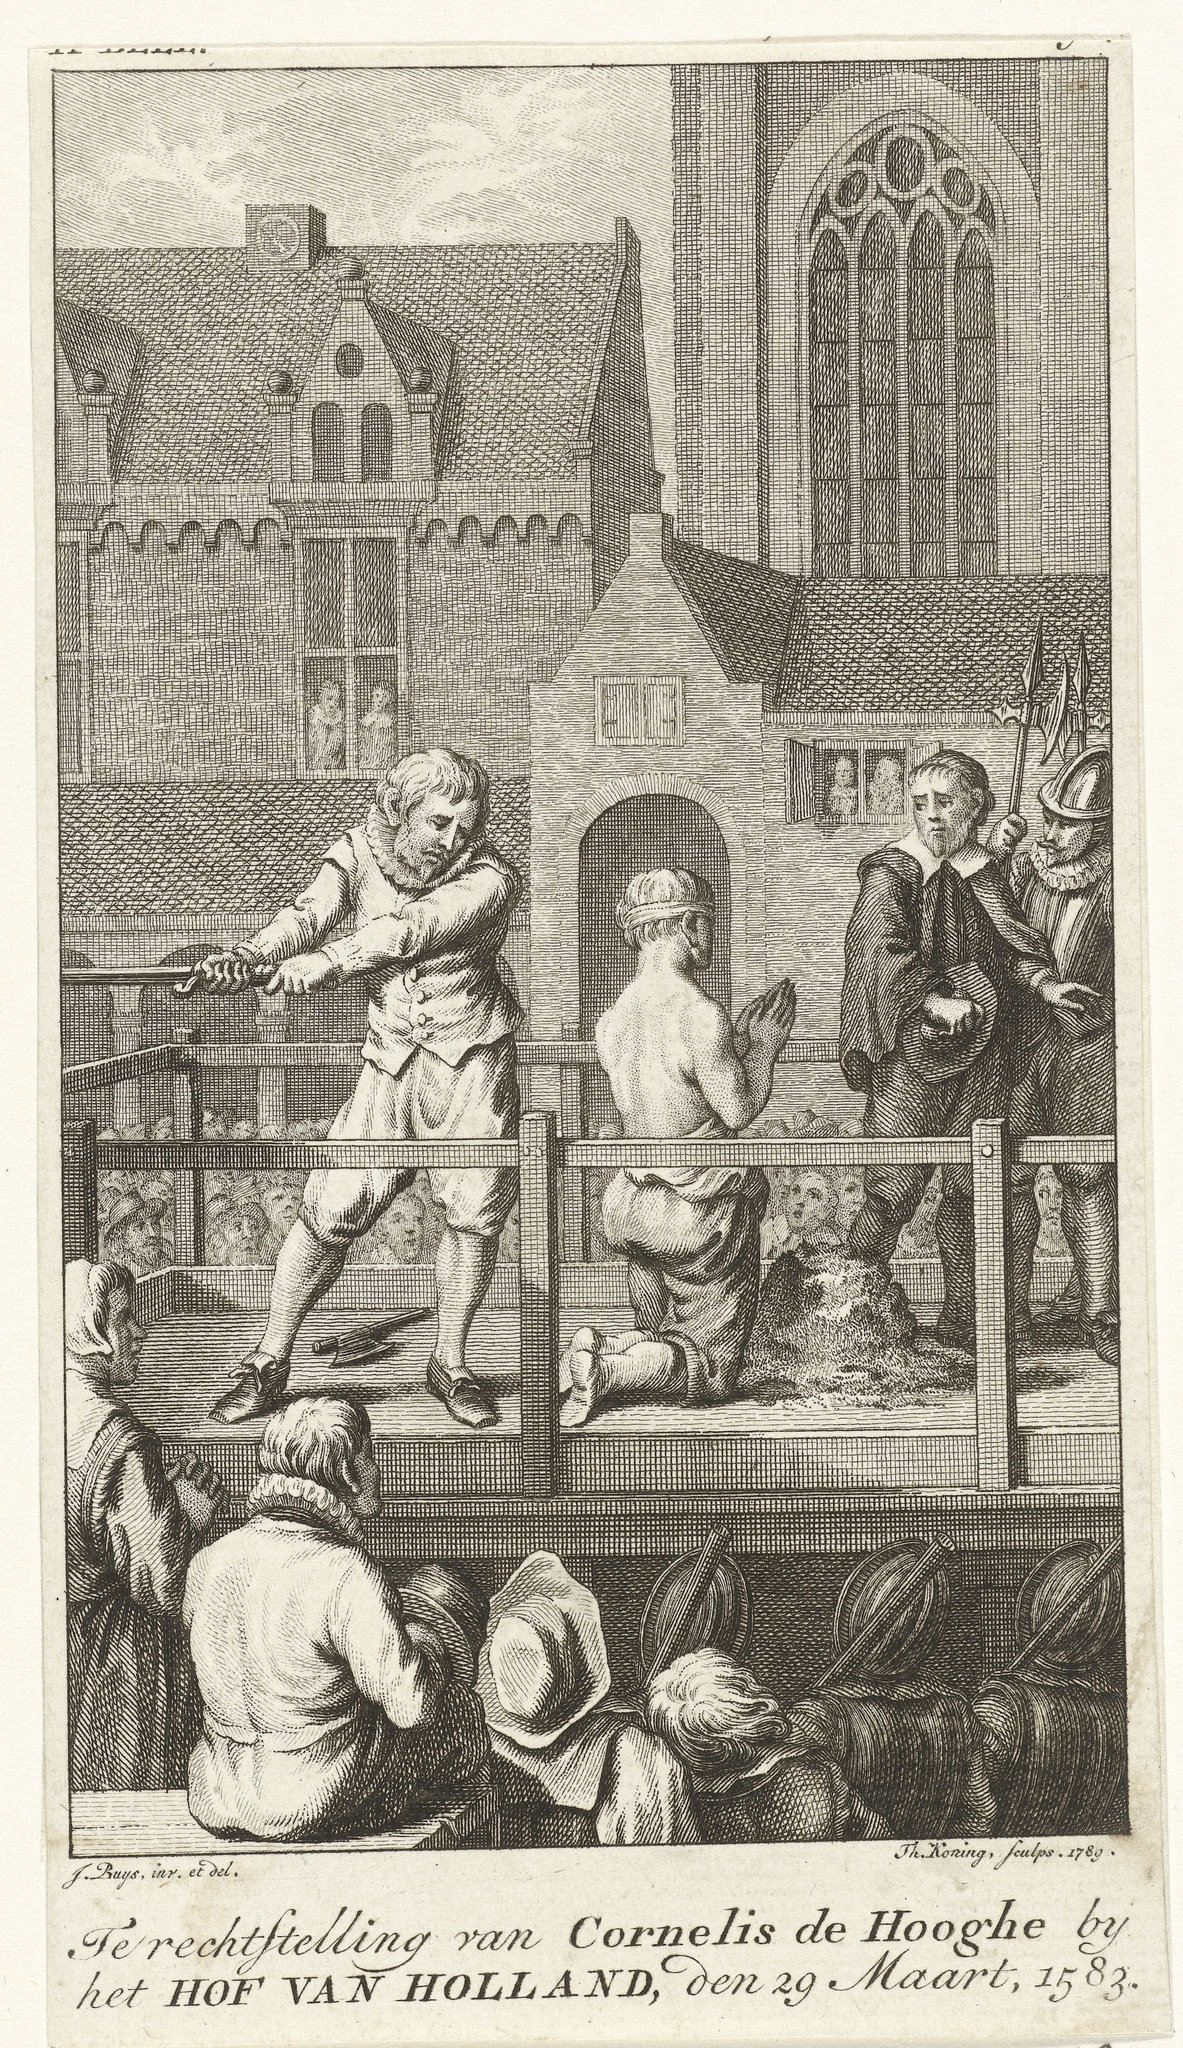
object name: print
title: Terechtstelling van Cornelis de Hooghe by het Hof van Holland, den 29 Maart, 1583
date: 1789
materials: paper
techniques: etching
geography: northern netherlands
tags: the hague, print maker, cornelis de hooghe, on the scaffold or place of execution, violent death by beheading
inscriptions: date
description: Onthoofding van de Leidse graveur Cornelis de Hooghe, 29 maart 1583. De man knielt met ontbloot bovenlichaam voor de beul op het schavot. De Hooghe werd veroordeeld wegens landverraad en onthoofd en gevierendeeld.